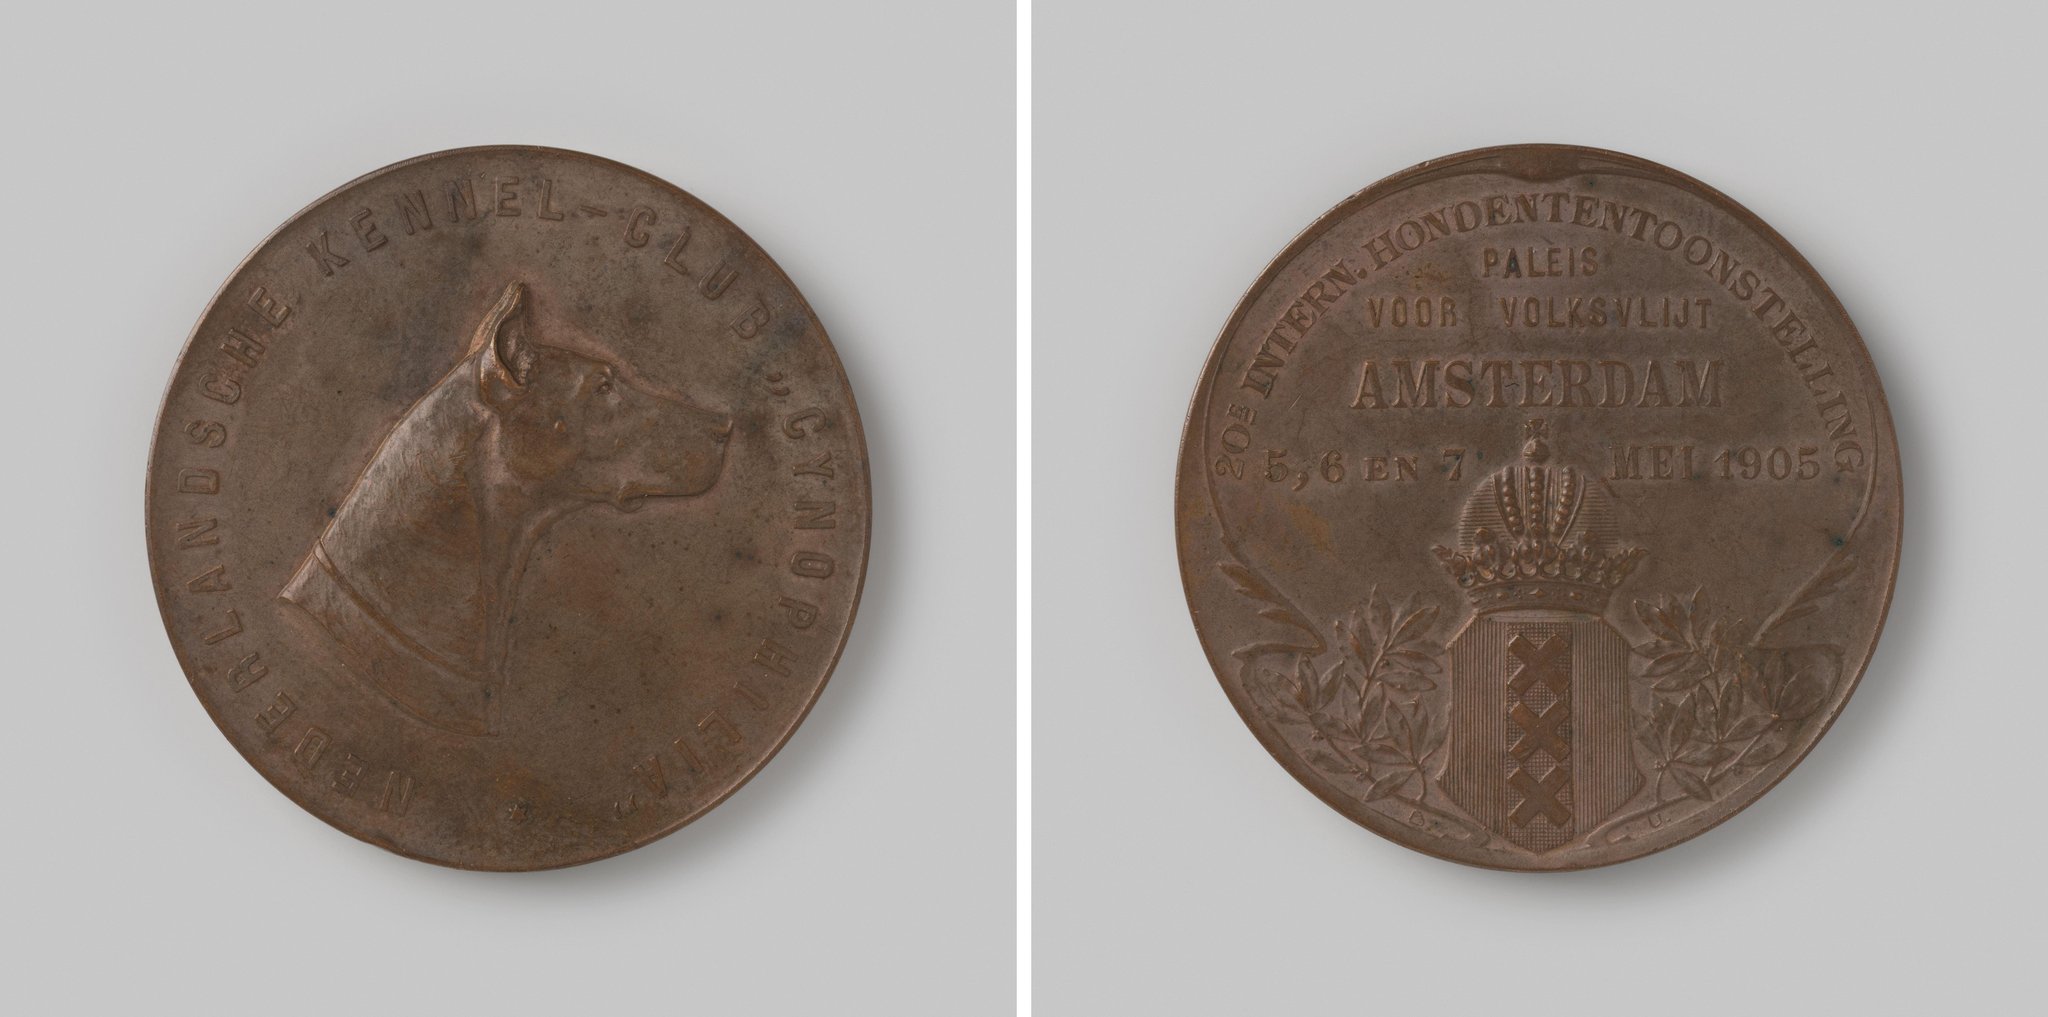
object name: history medal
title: Twintigste internationale hondententoonstelling in het Paleis voor Volksvlijt te Amsterdam, uitgegeven door de Nederlandsche Kennel-club Cynophilia 1905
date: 1905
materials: bronze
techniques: striking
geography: utrecht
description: Bronzen penning, op de voorzijde een hondenkop naar rechts met omschrift, op de keerzijde vijf regels tekst boven het Amsterdamse stadswapenschild tussen lauwertakken.